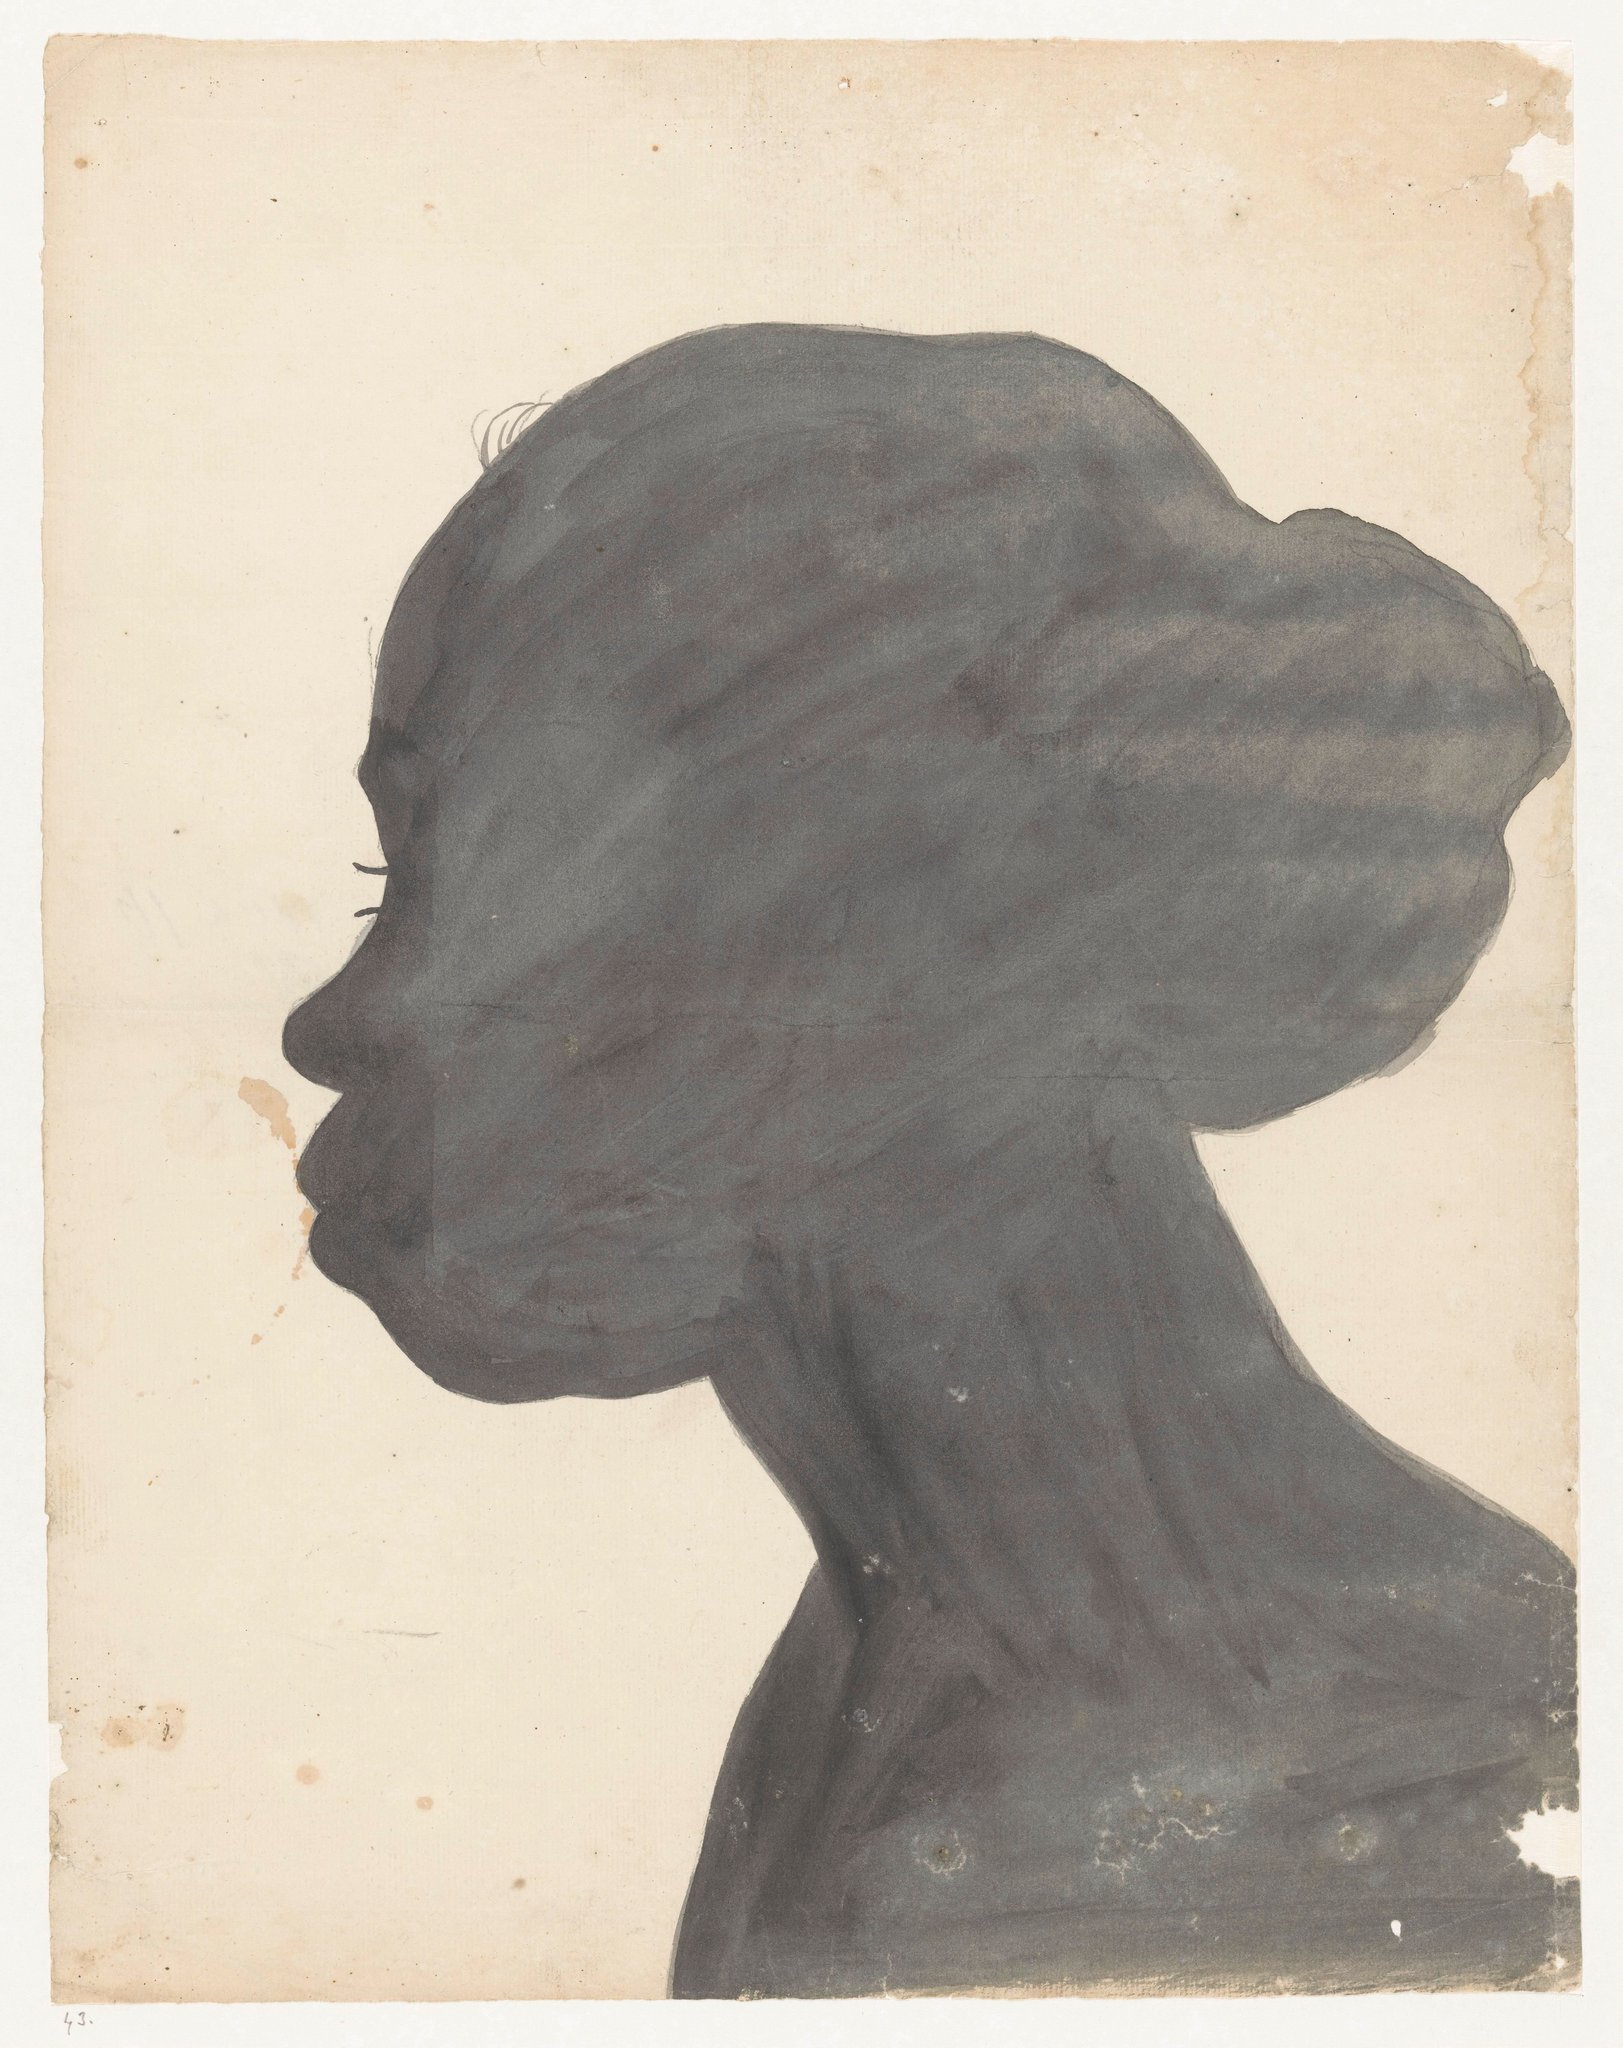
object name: drawing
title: Silhouetportret van Flora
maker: jan brandes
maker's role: draughtsman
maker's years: 1743-1808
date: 1783-1784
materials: ink, paper, pencil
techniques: brush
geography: batavia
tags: historical persons - bb - woman, slavery; serfs and enslaved persons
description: Portret in silhouet van Flora, een tot slaaf gemaakte vrouw uit de huishouding van de tekenaar Jan Brandes.